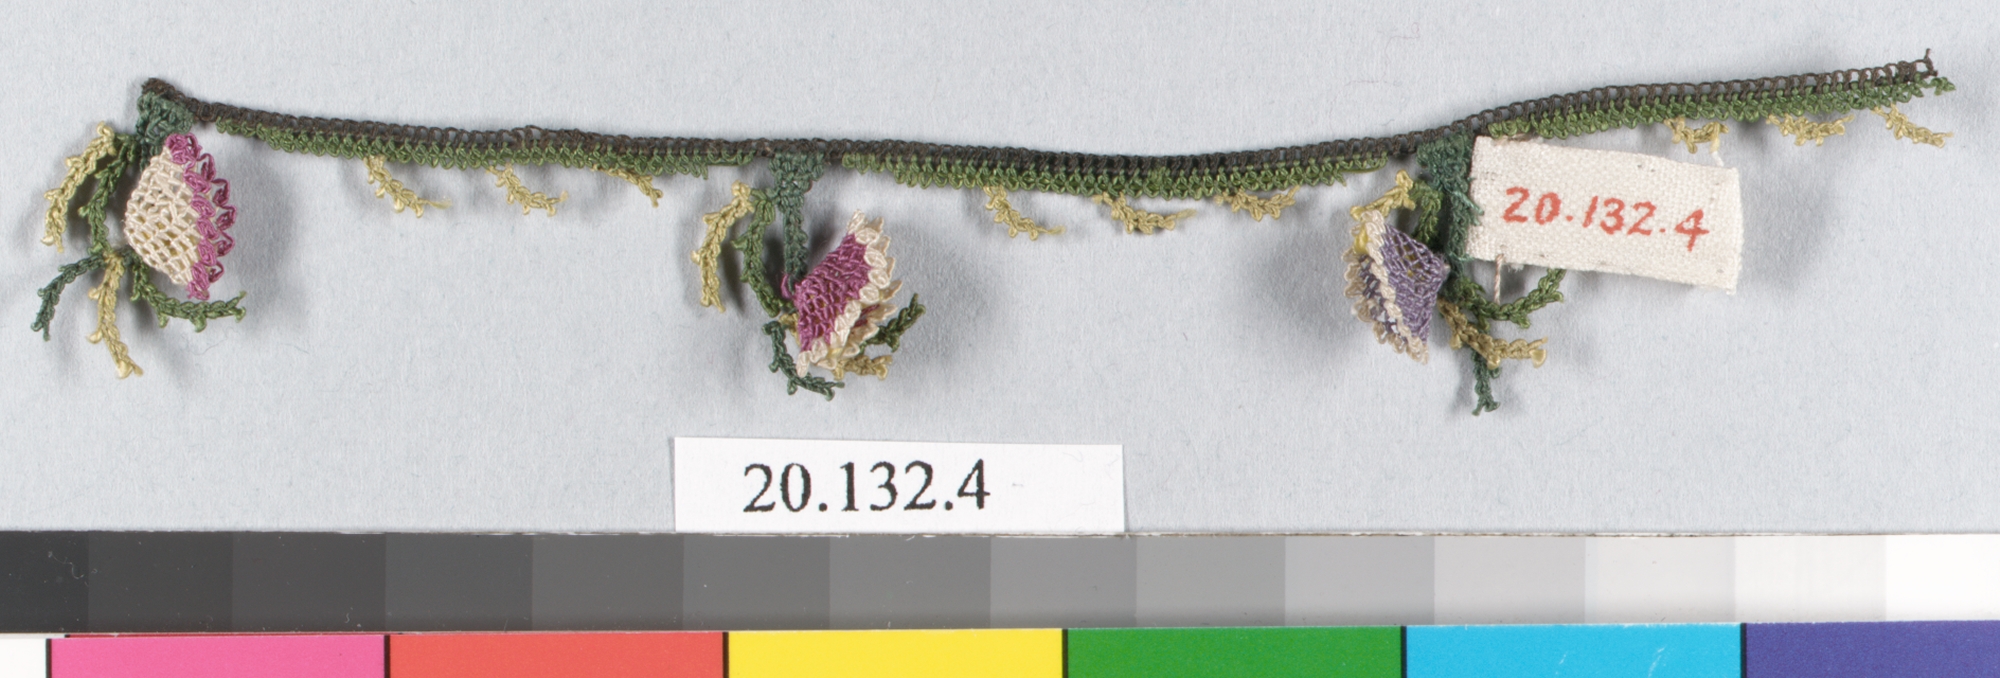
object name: oyah bibilia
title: Oyah (Biblia)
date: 1801-1900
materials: silk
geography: turkey